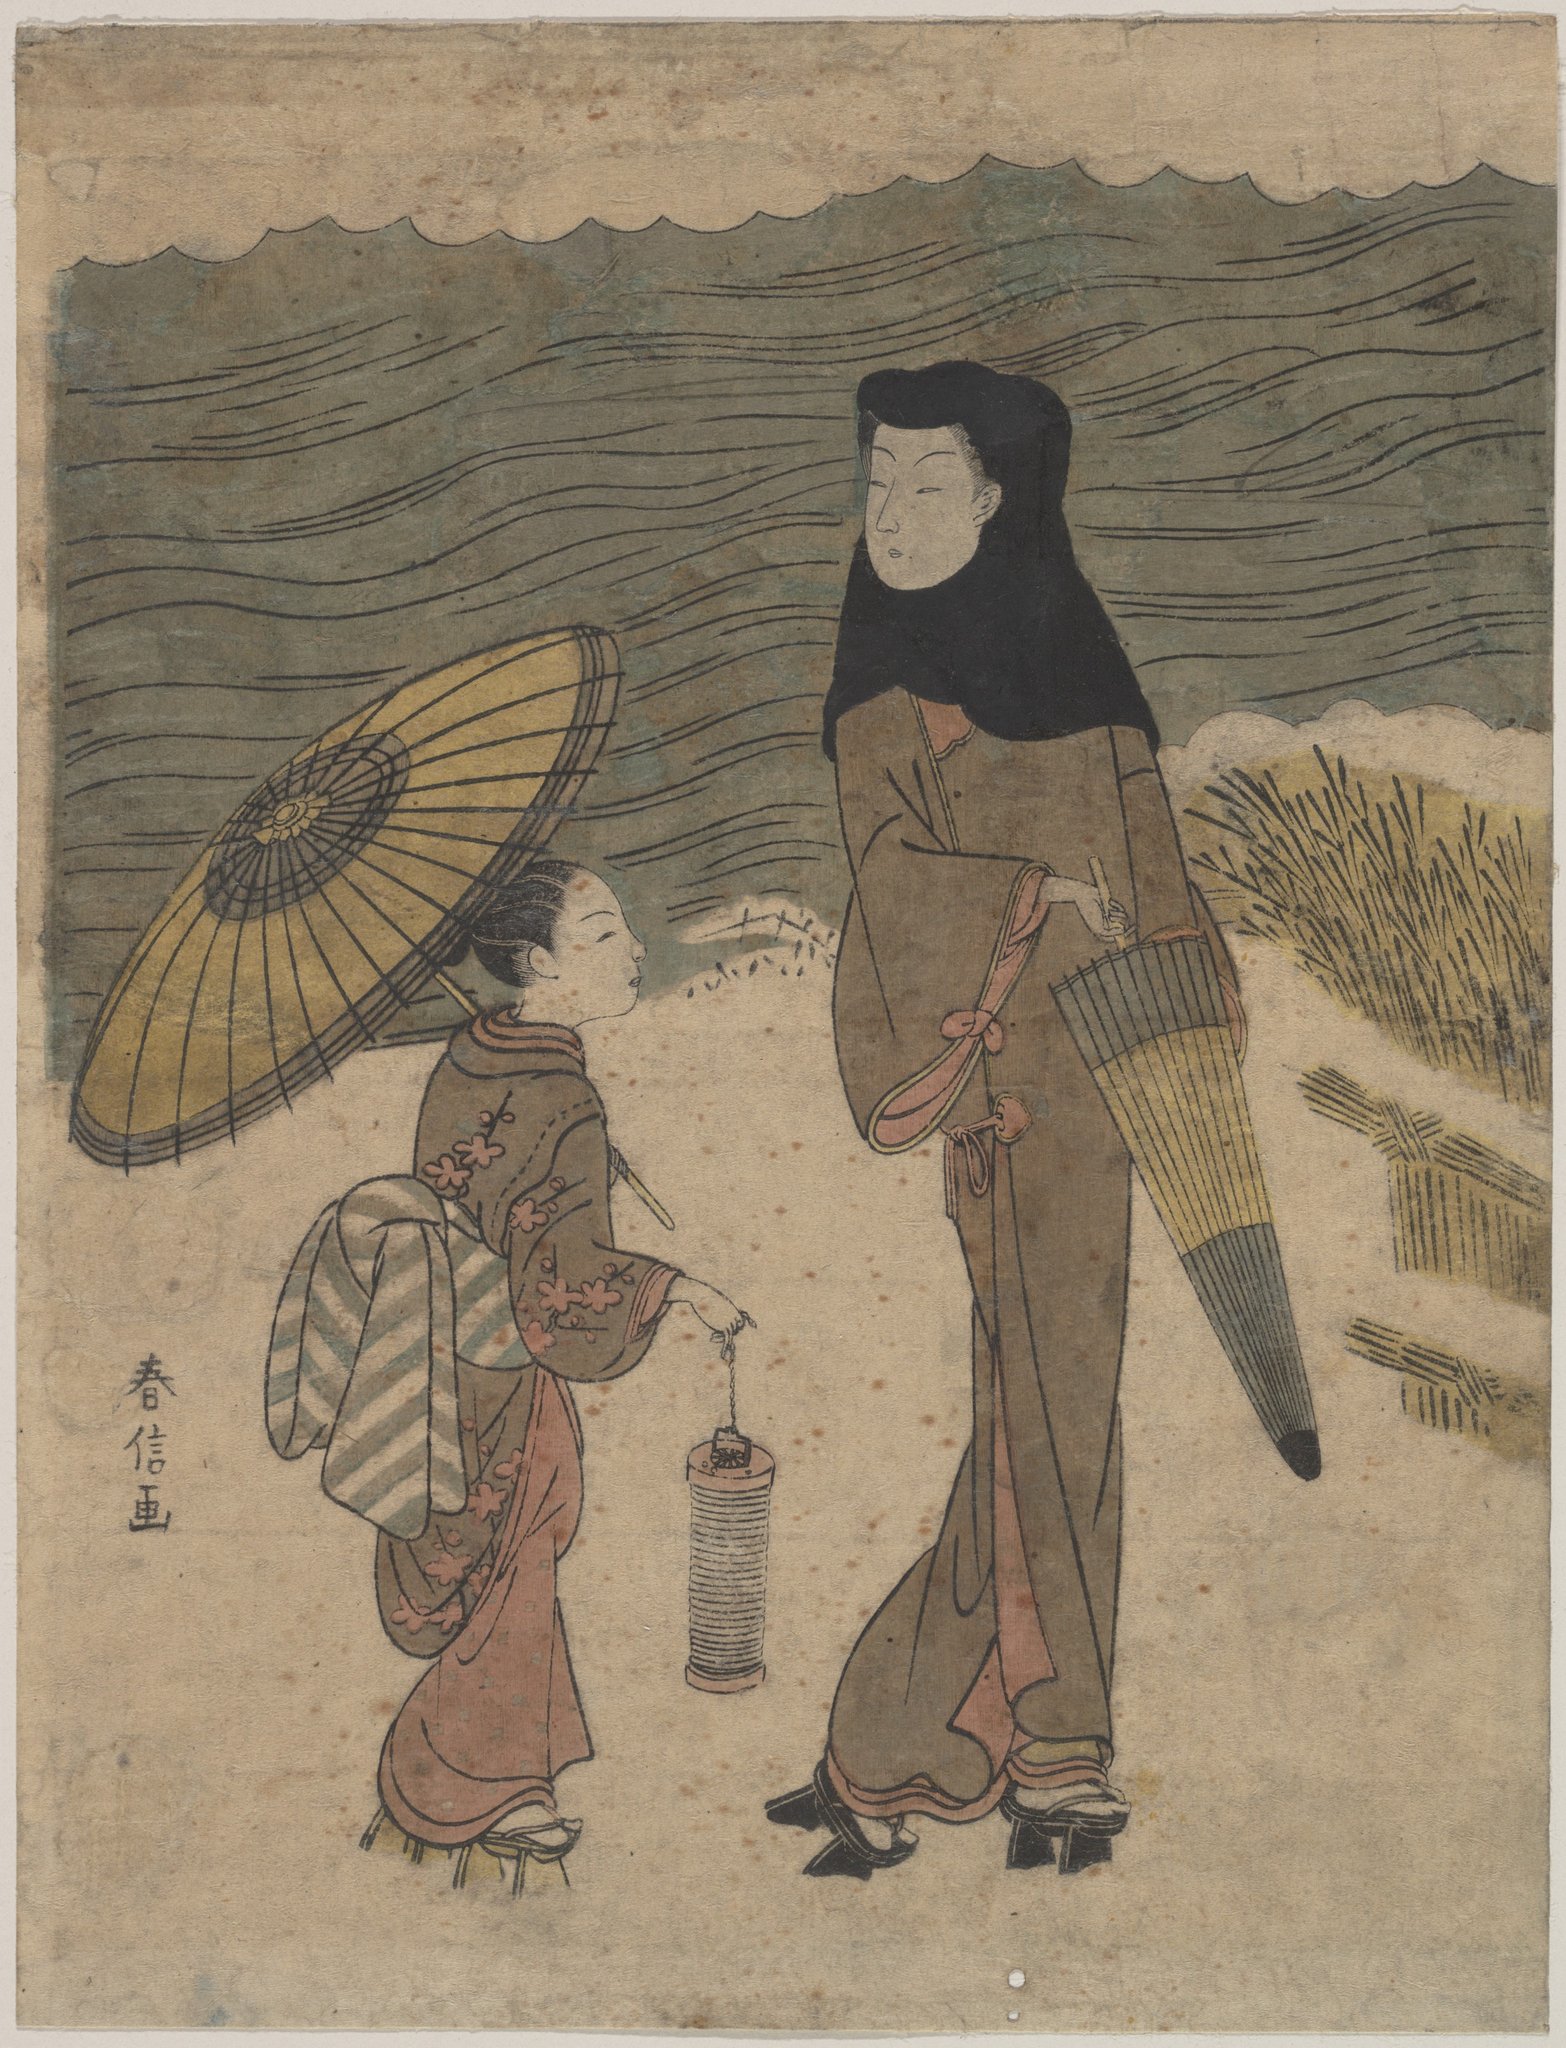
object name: print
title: Lady with Black Hood and Umbrella Out Walking with Young Attendant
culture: japanese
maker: suzuki harunobu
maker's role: artist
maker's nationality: japanese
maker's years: 1725-1770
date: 1725-1770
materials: ink, paper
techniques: woodblock print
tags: girls,women,umbrellas